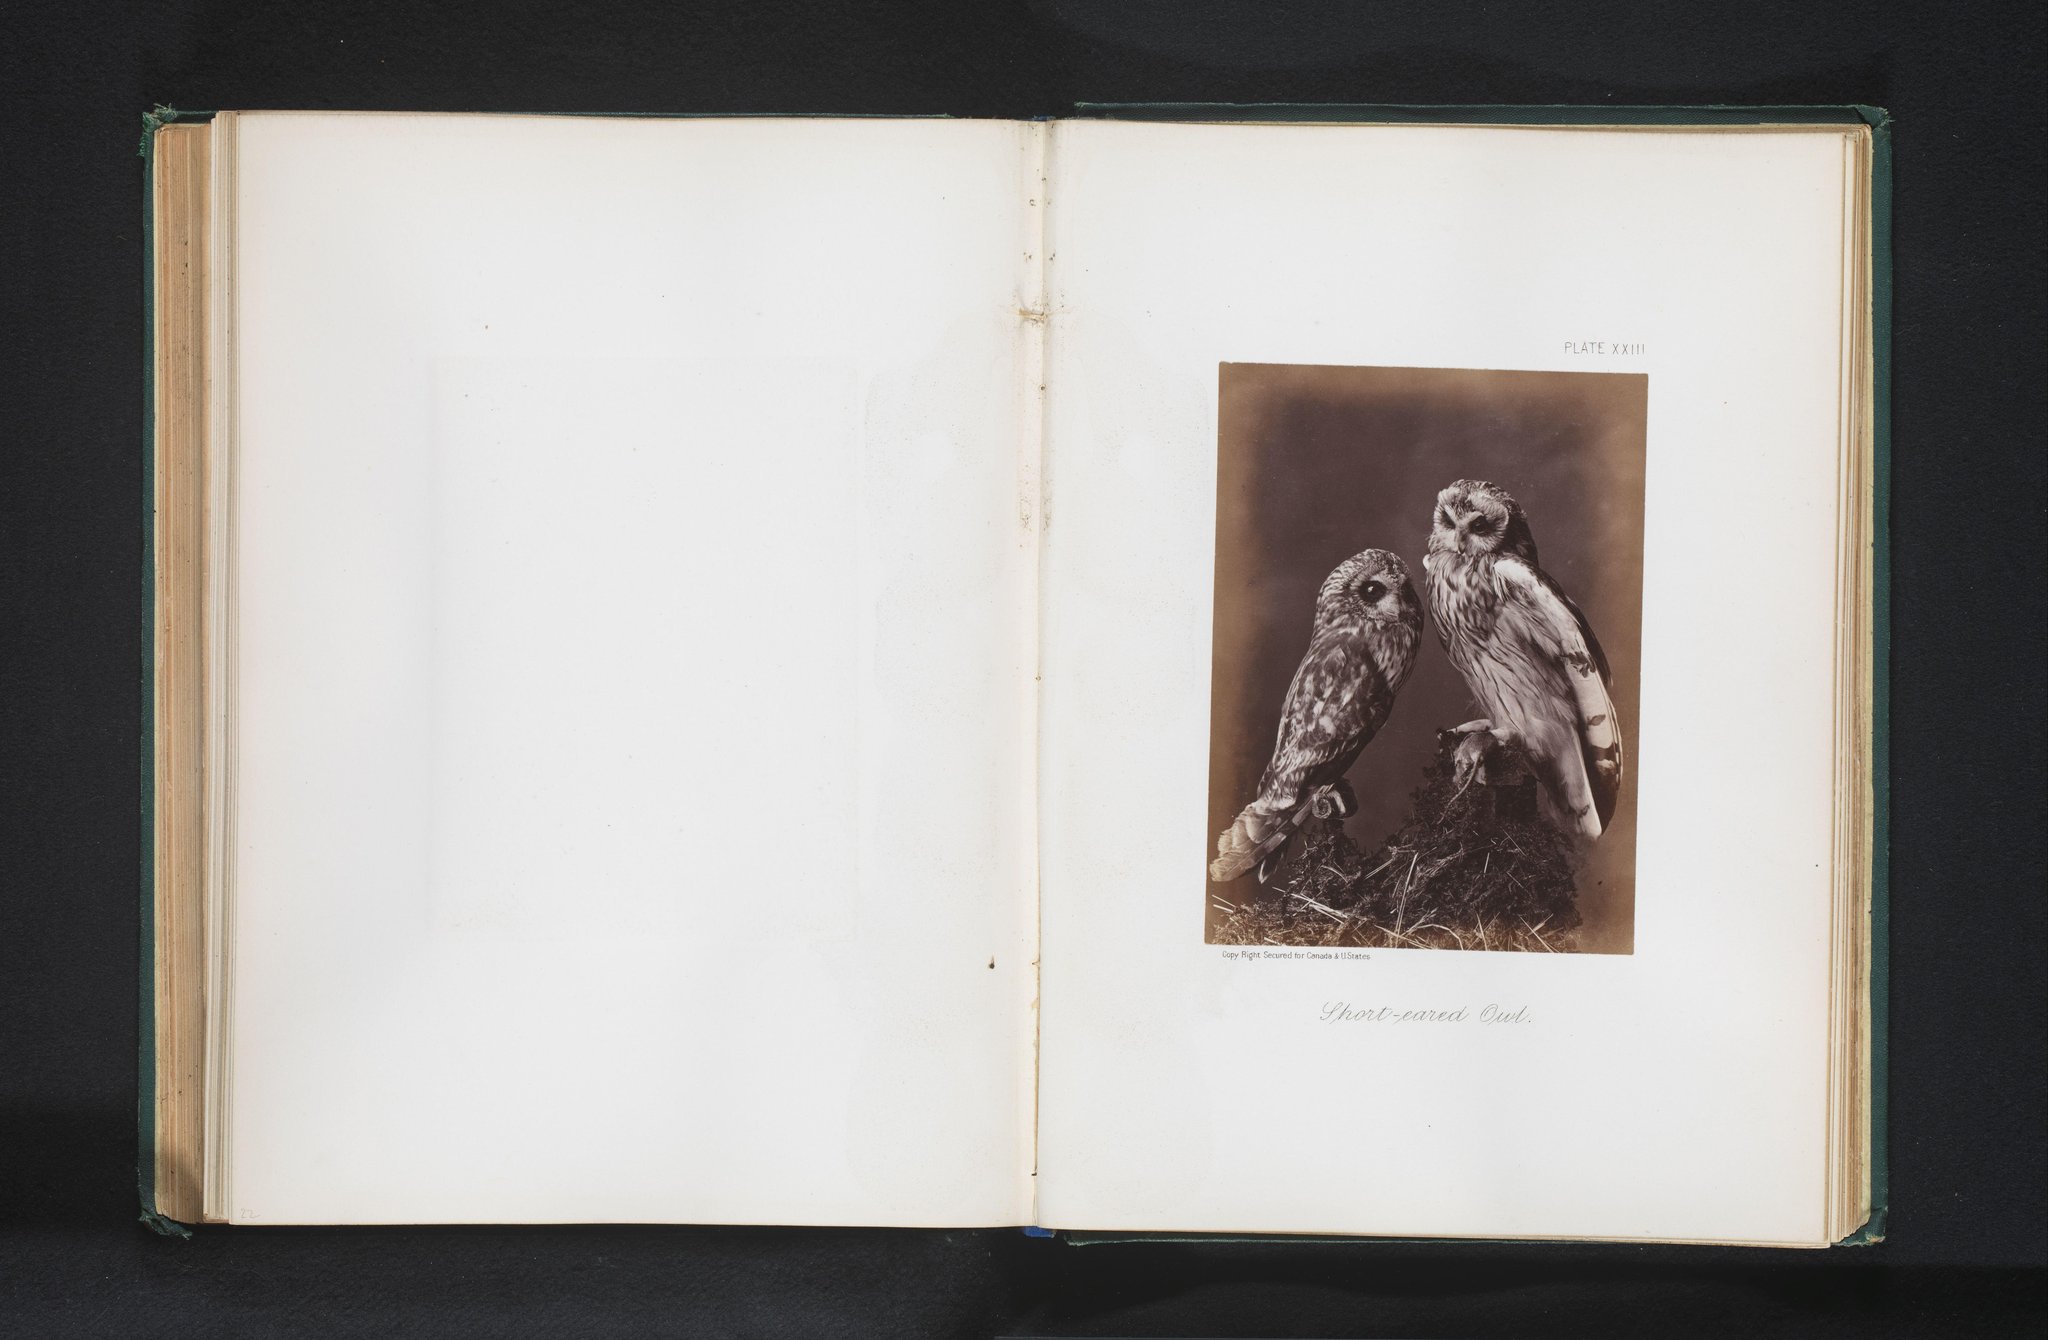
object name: page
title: Short-eared Owl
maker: william notman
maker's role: fotograaf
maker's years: 1826-1891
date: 1871-1876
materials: paper, photographic support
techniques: albumen print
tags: collection of animals, owls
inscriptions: inscription: ‘Copy Right Secured for Canada & U.States’, number: ‘PLATE XXIII’